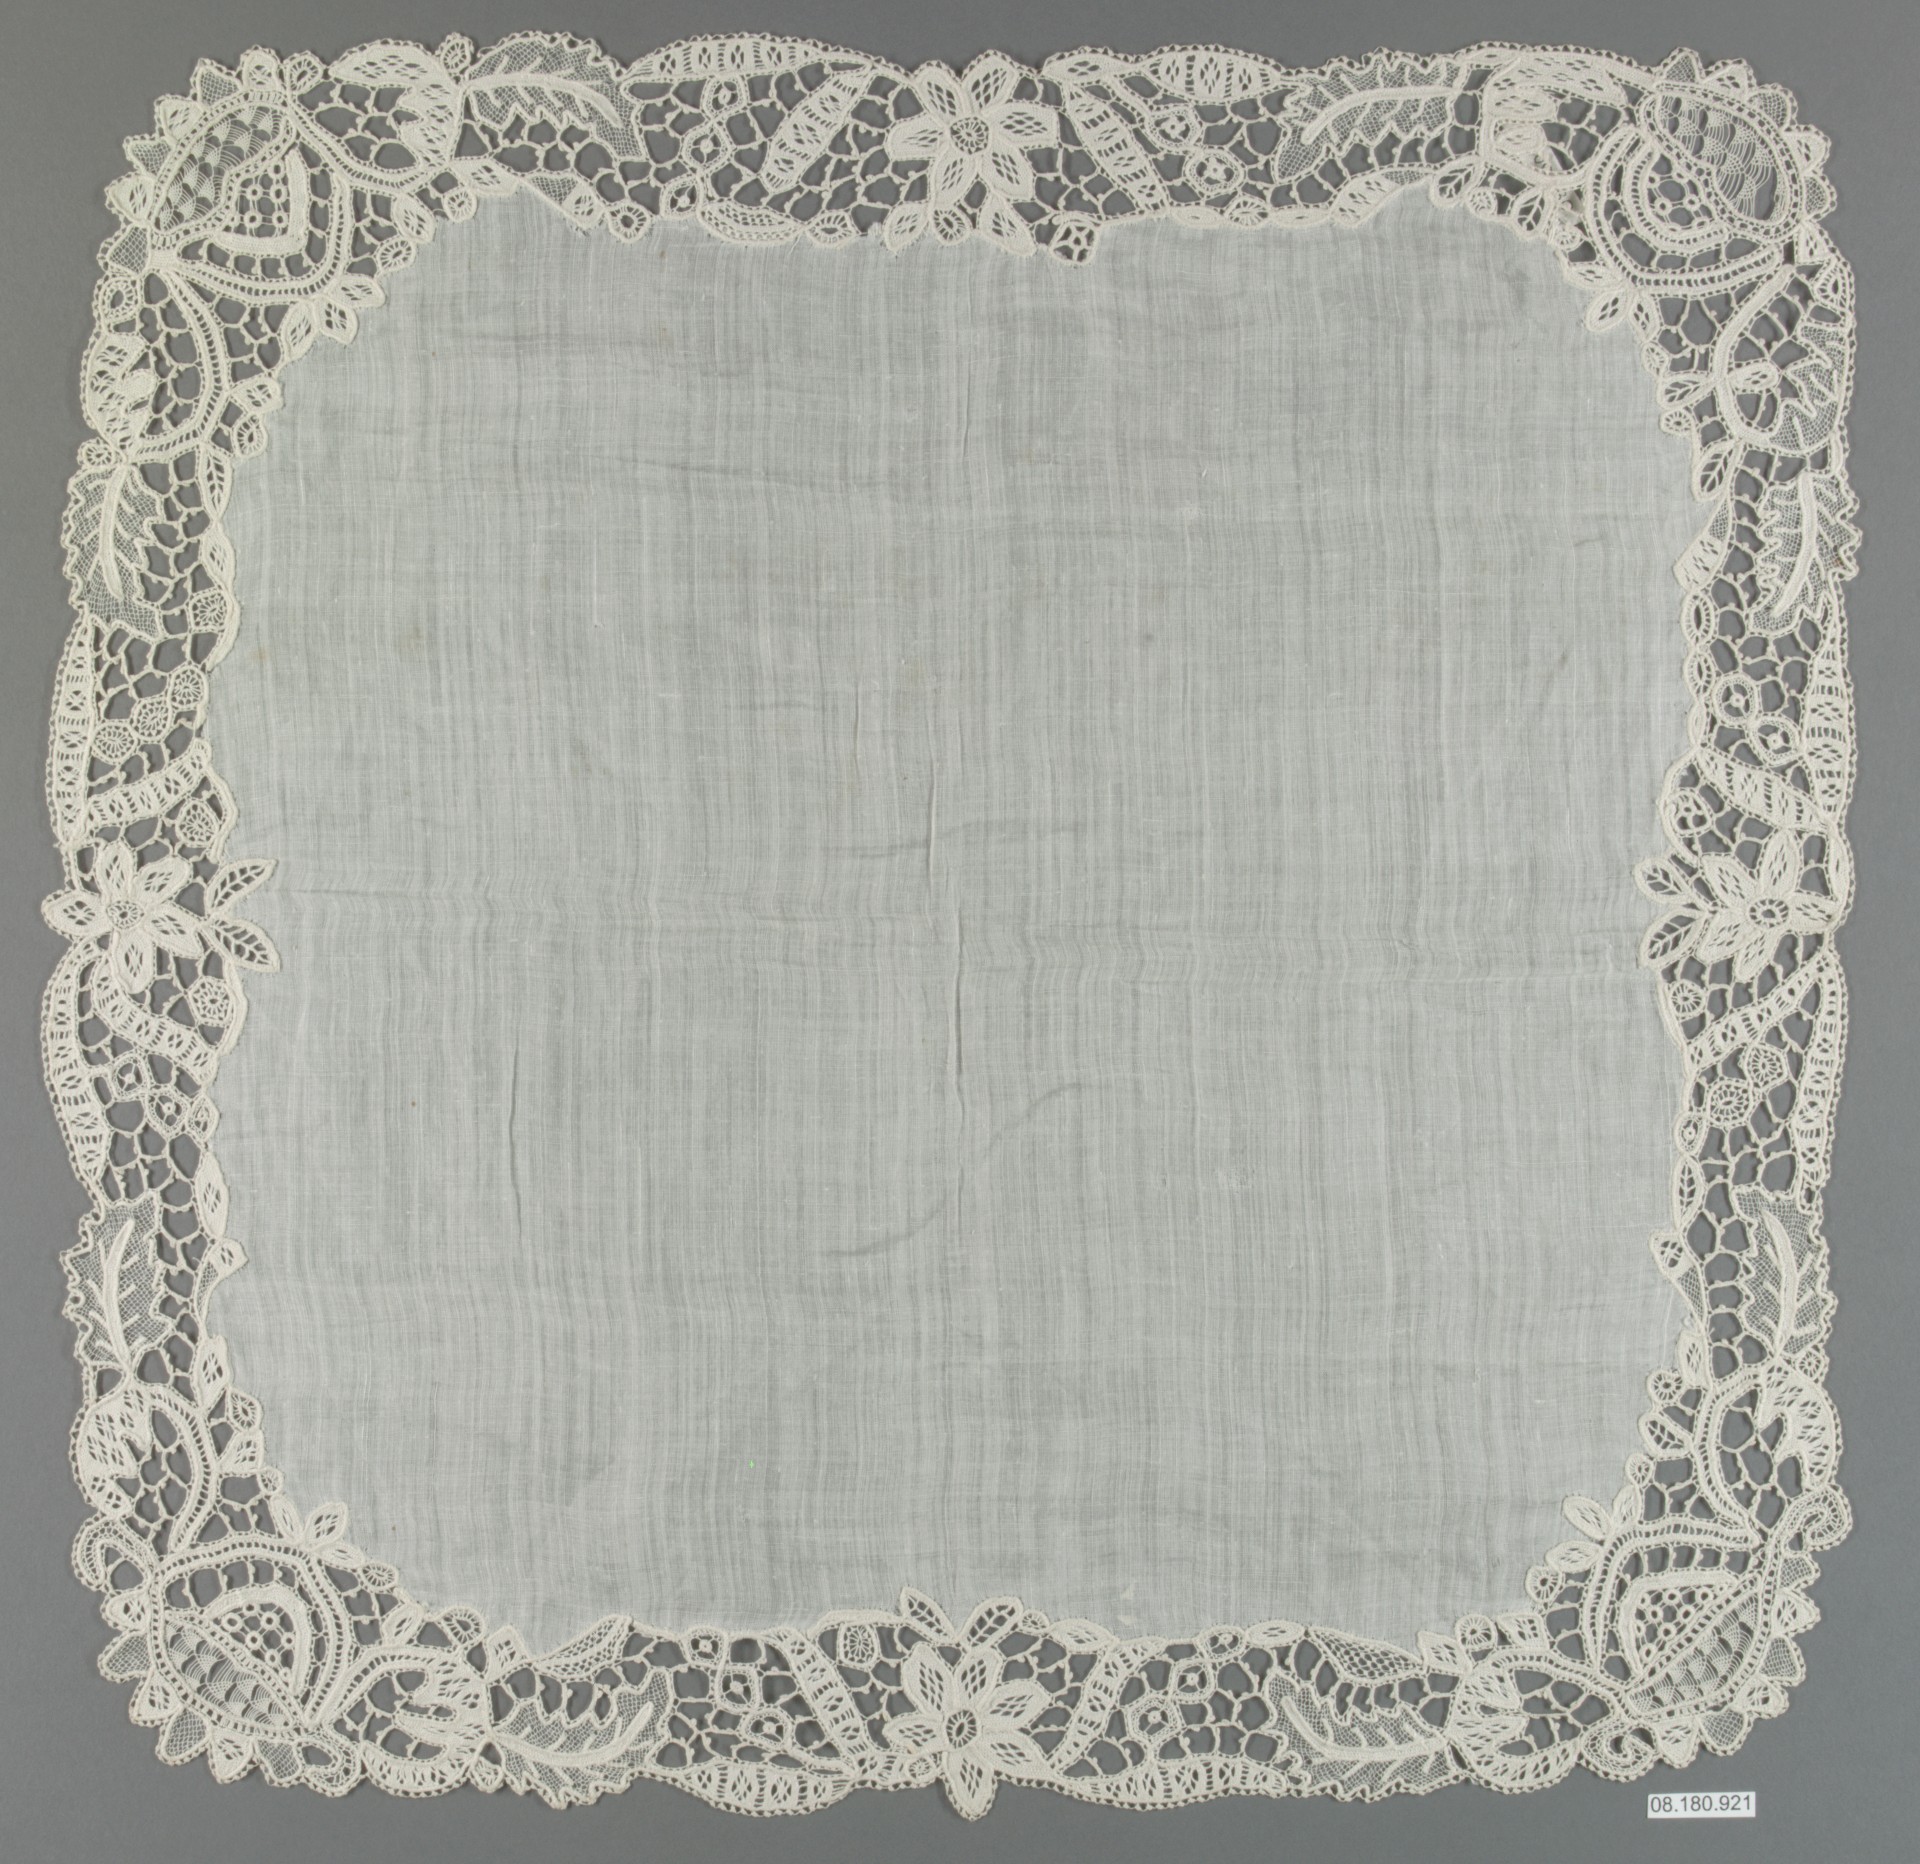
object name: handkerchief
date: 1801-1900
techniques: lace